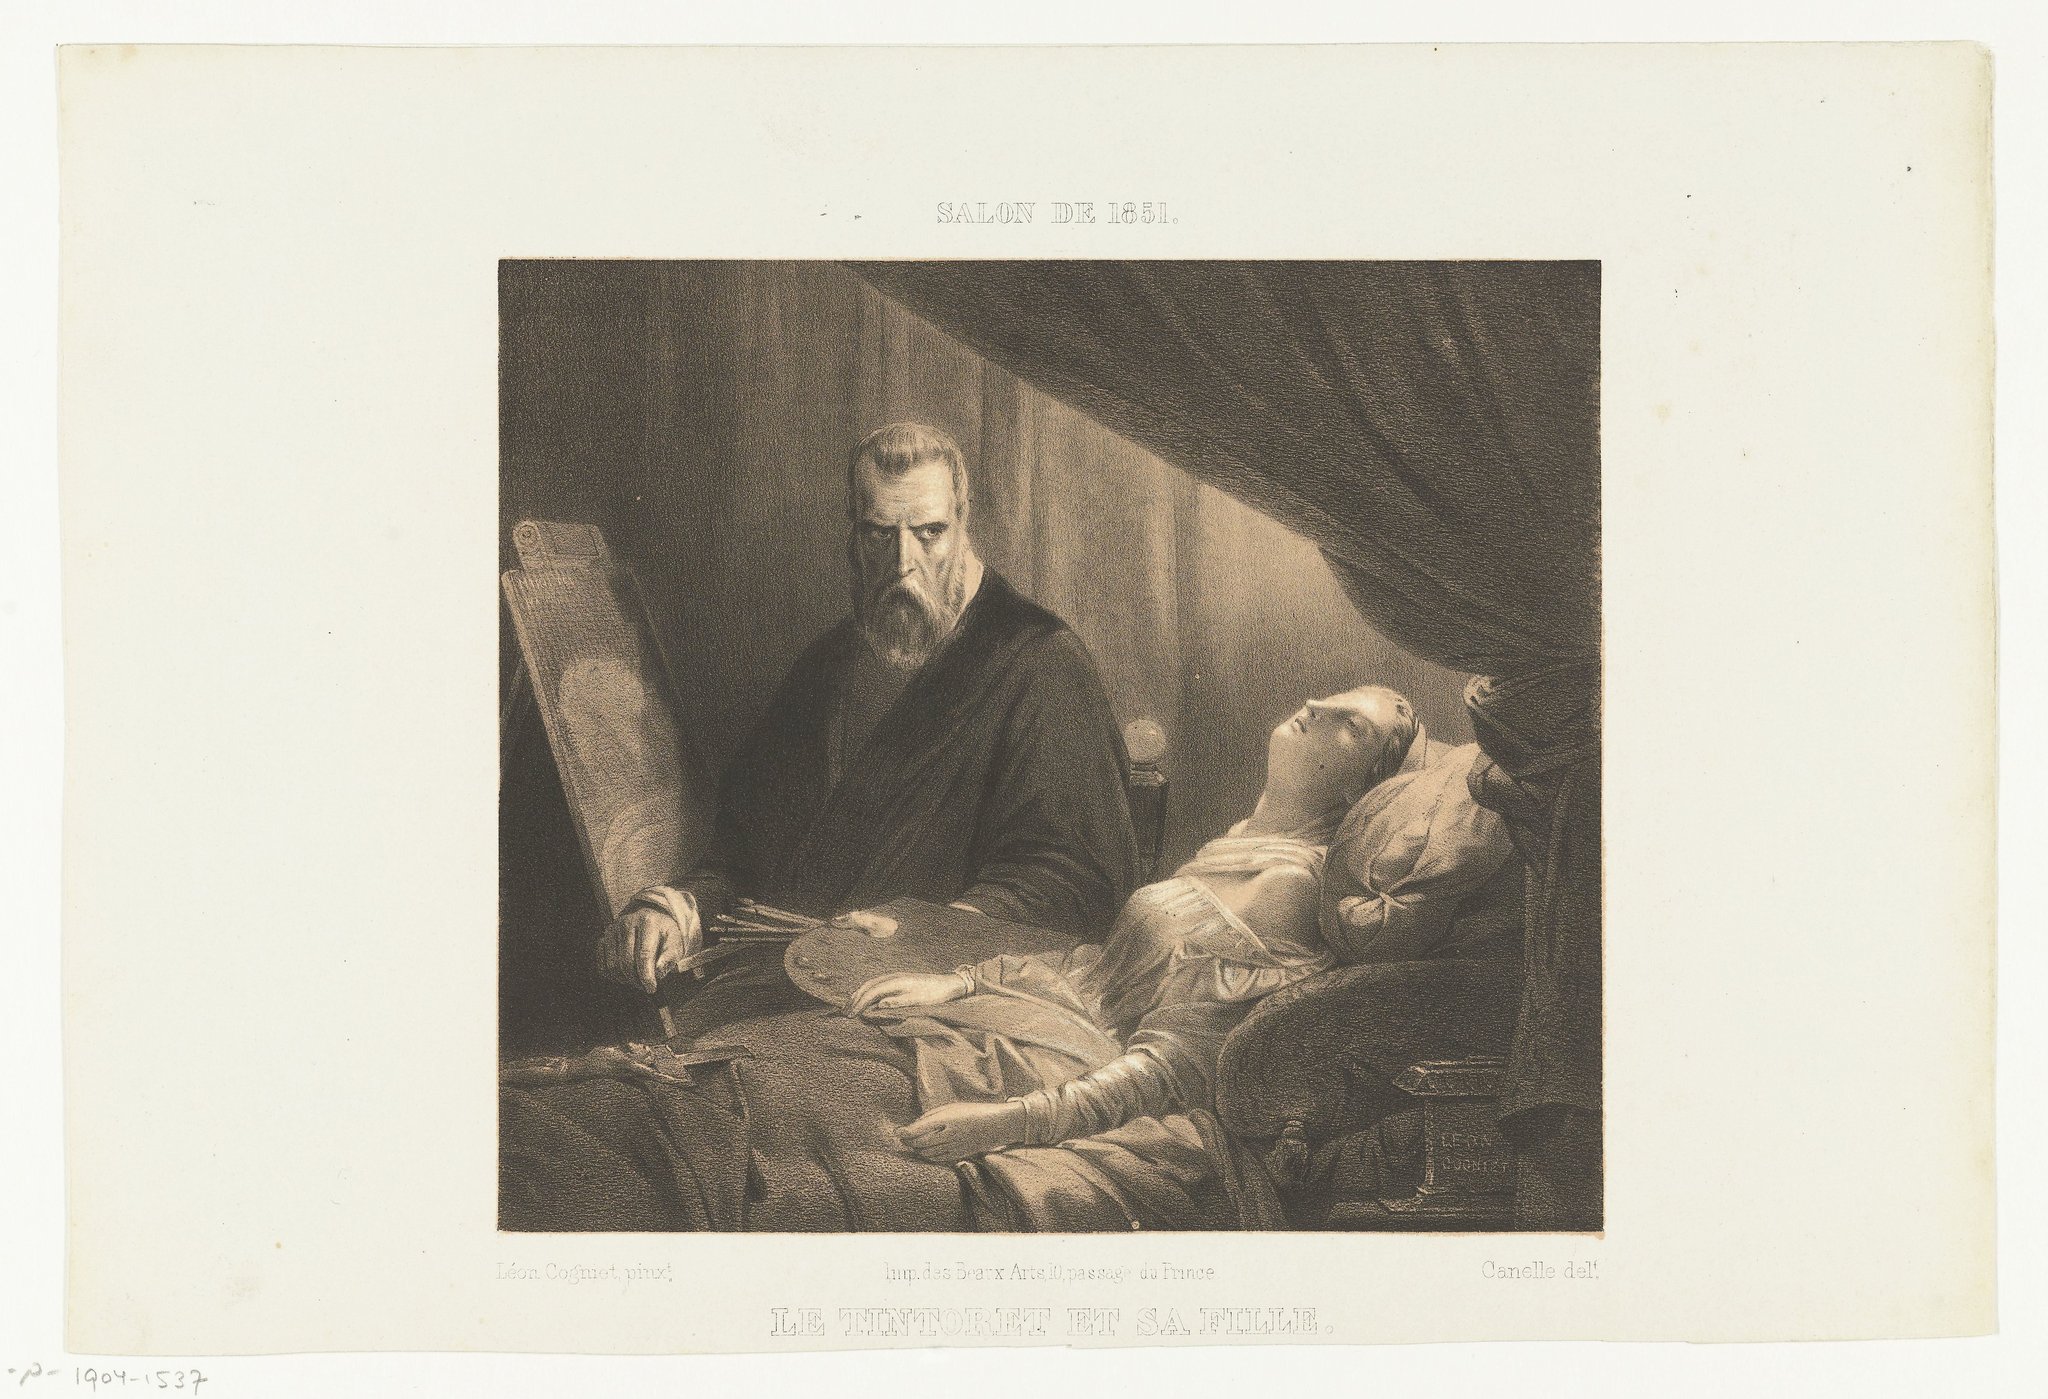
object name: print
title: Le Tintoret et sa fille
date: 1829-1869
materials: paper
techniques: tone lithography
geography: brussels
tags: venice, painter, print maker, draughtsman, jacopo tintoretto, painter working from live model, deathbed, historical persons, tools, implements of painter, crucifix ~ personal devotion, drapery, draped garment, 'gewandgebung'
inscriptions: collector's mark: Lugt 2228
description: De schilder zit naast het bed van de jonge vrouw. Voor hem staat een ezel en in zijn hand heeft hij kwasten en een palet. Aan het voeteneinde van het bed ligt een crucifix op de dekens. Rechts hangt een opgetrokken gordijn.